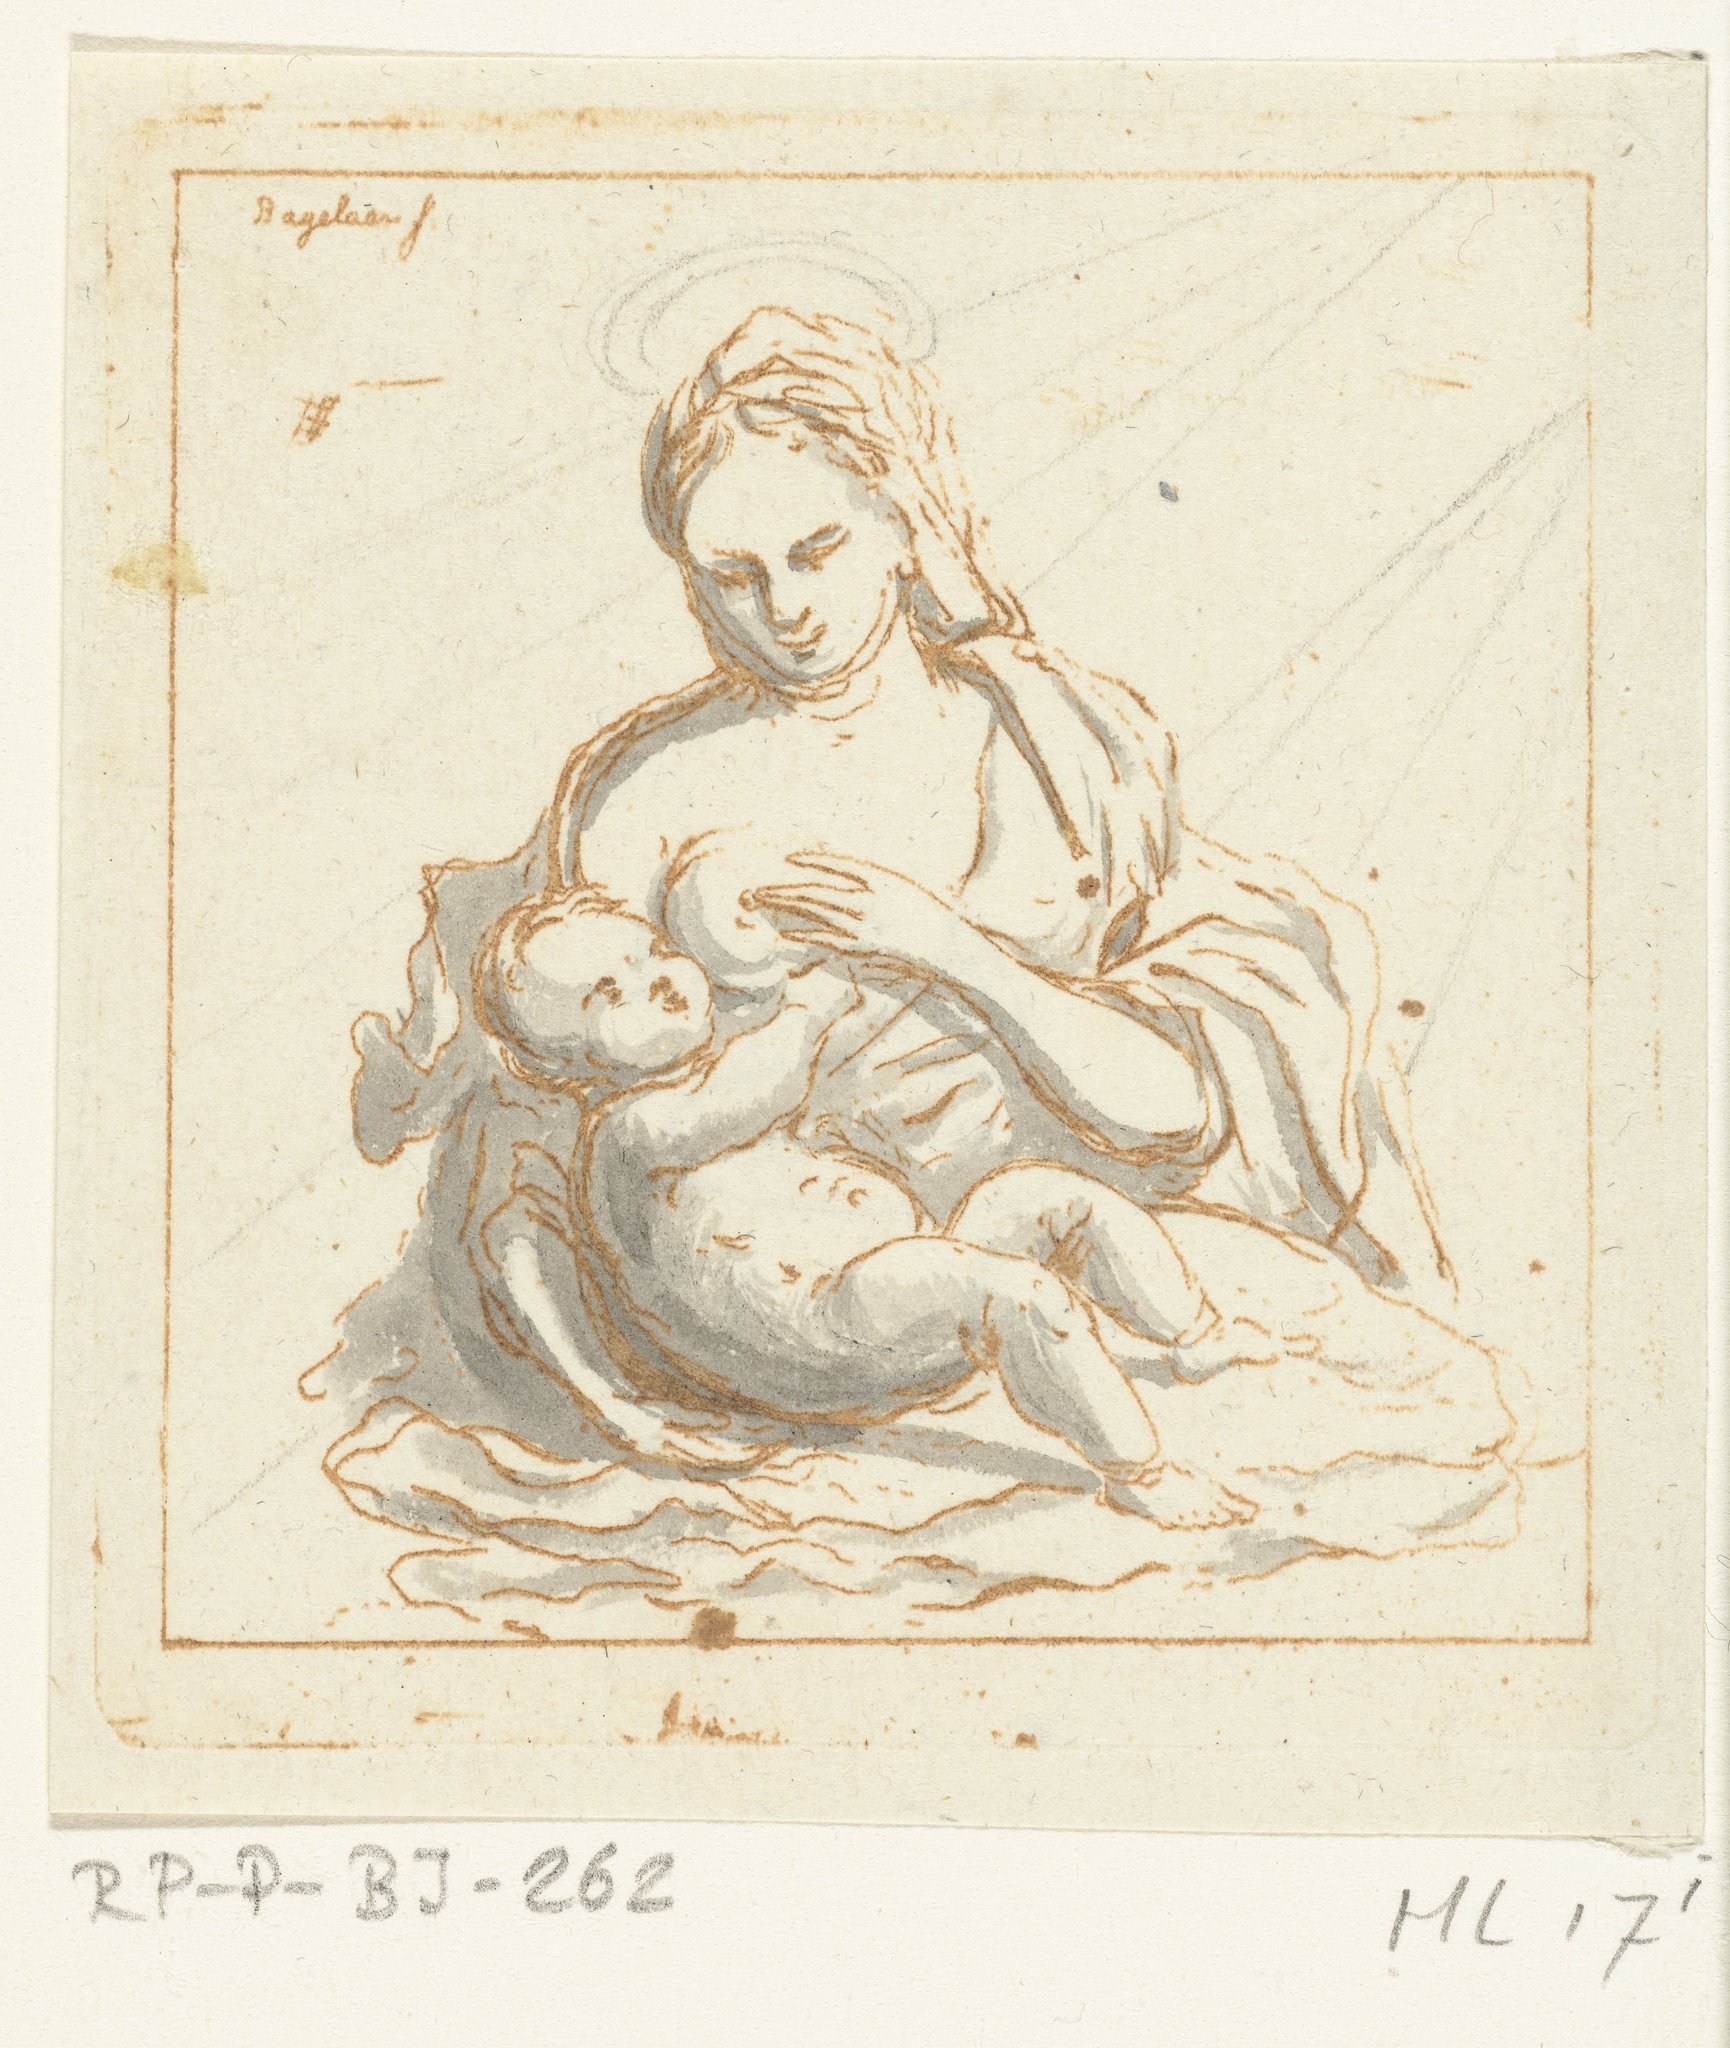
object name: print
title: Maria geeft Christus de borst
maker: ernst willem jan bagelaar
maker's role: draughtsman, print maker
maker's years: 1775-1837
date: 1798-1837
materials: paper, pencil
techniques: brush, etching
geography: netherlands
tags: christ-child suckling, or beginning to suckle, e.g. mary uncovering her breast ~ madonna-representations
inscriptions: collector's mark: Lugt 2228